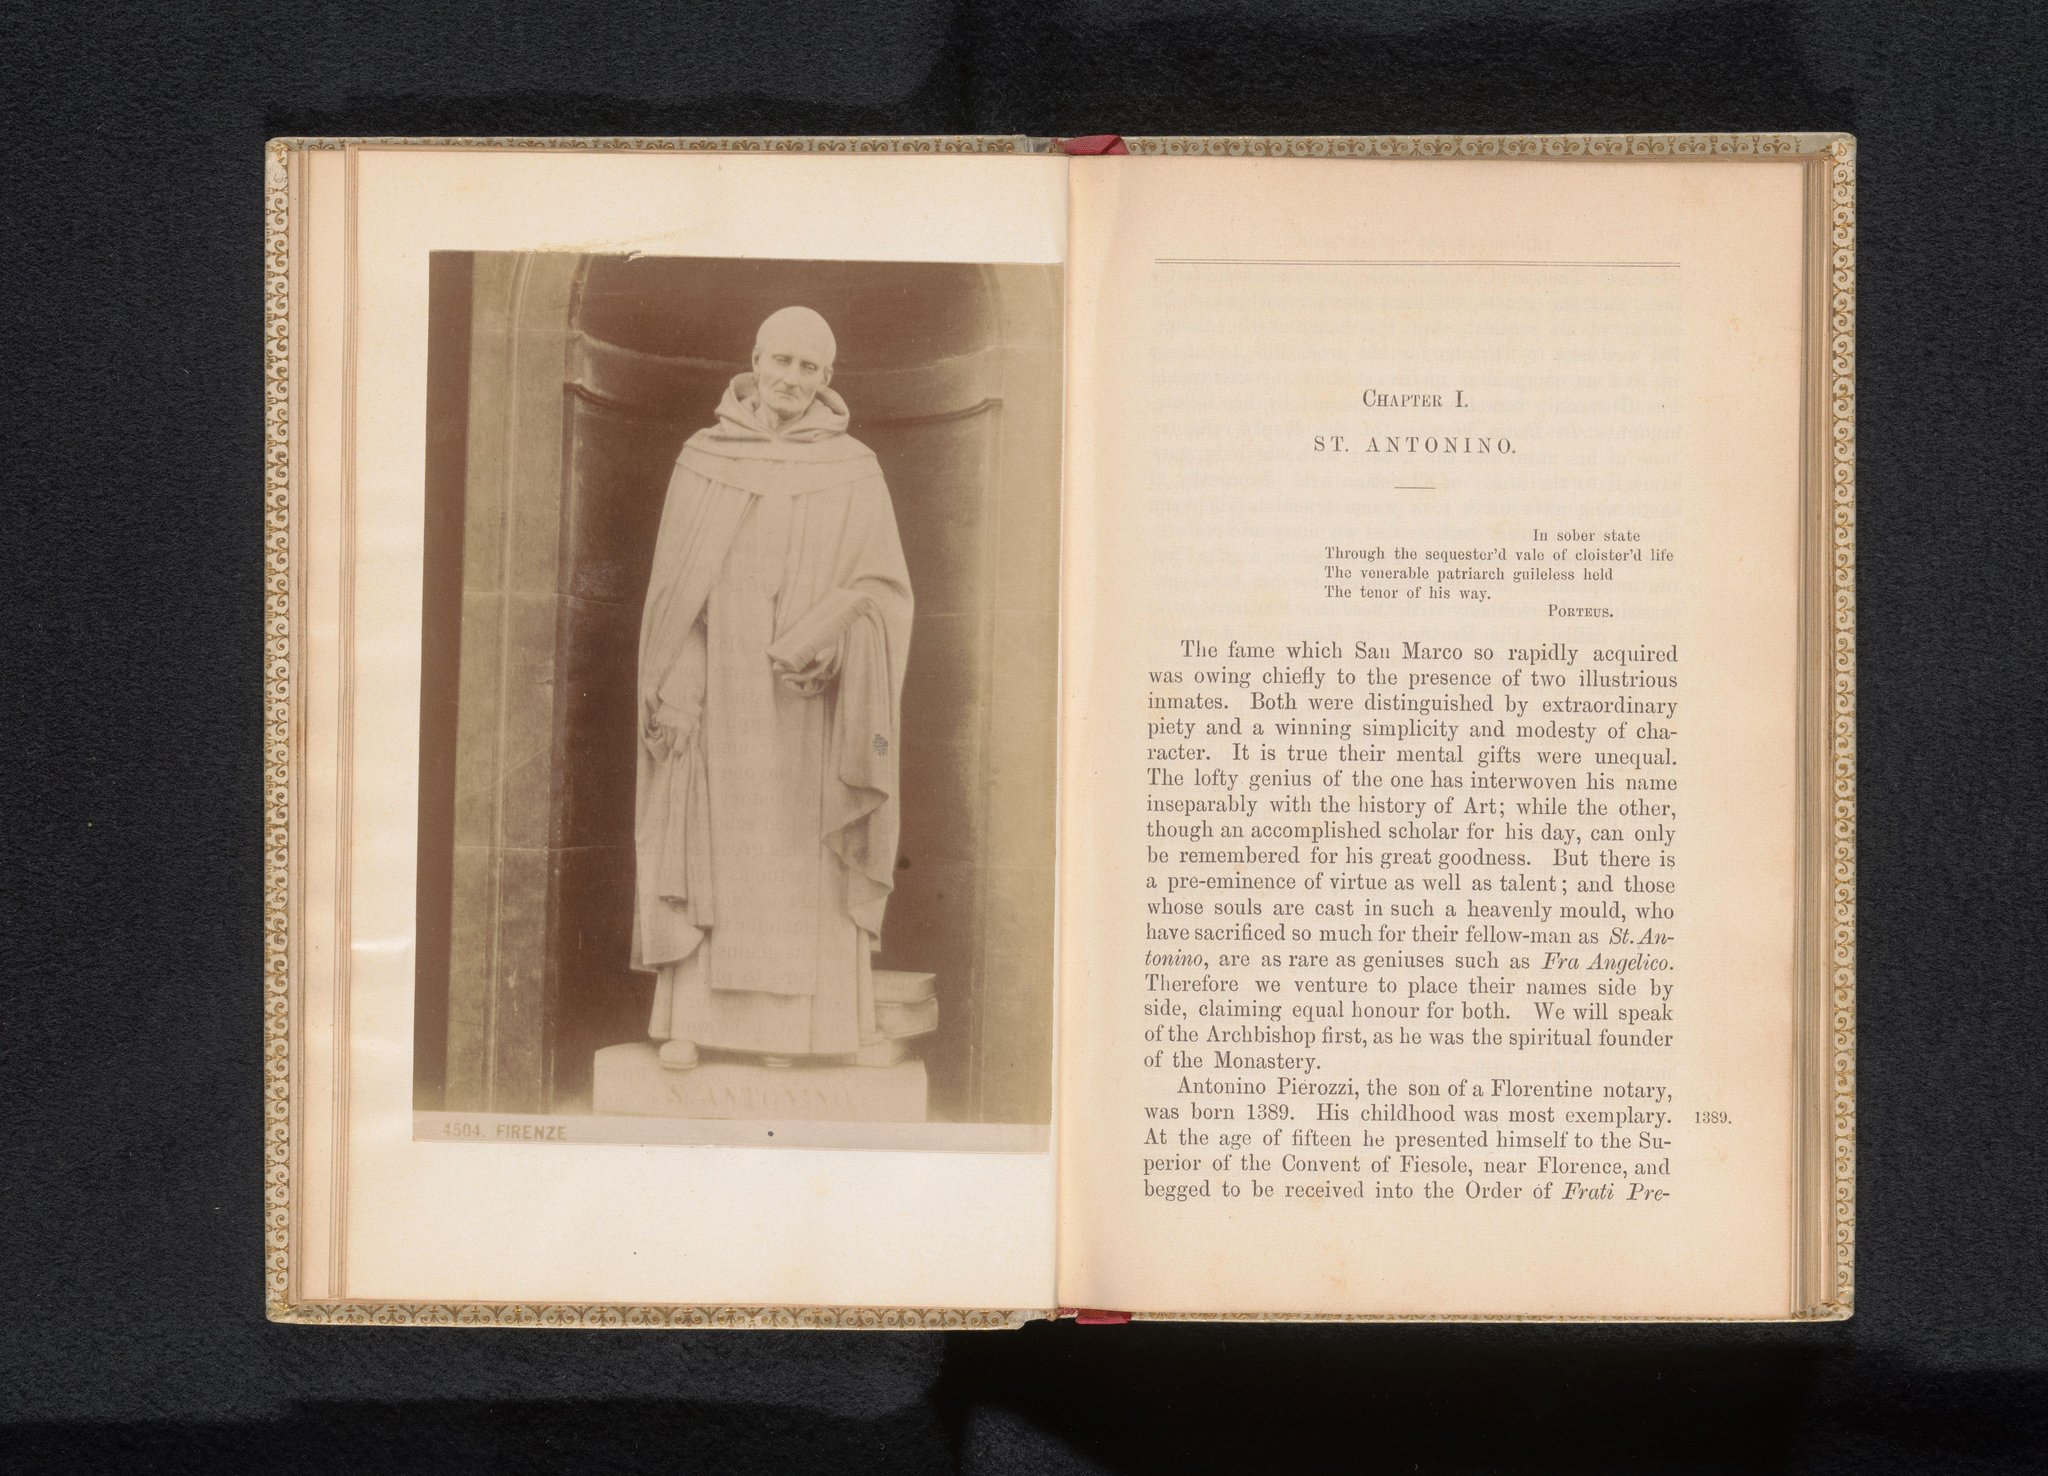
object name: page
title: Standbeeld van de heilige Antoninus van Florence buiten de Galleria degli Uffizi te Florence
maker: Anonymous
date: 1880-1890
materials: photographic support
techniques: albumen print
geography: florence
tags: antoninus pierozzi, dominican friar and archbishop of florence; possible attributes: book, scales, sculpture, façade (of house or building)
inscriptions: number: ‘4504.’